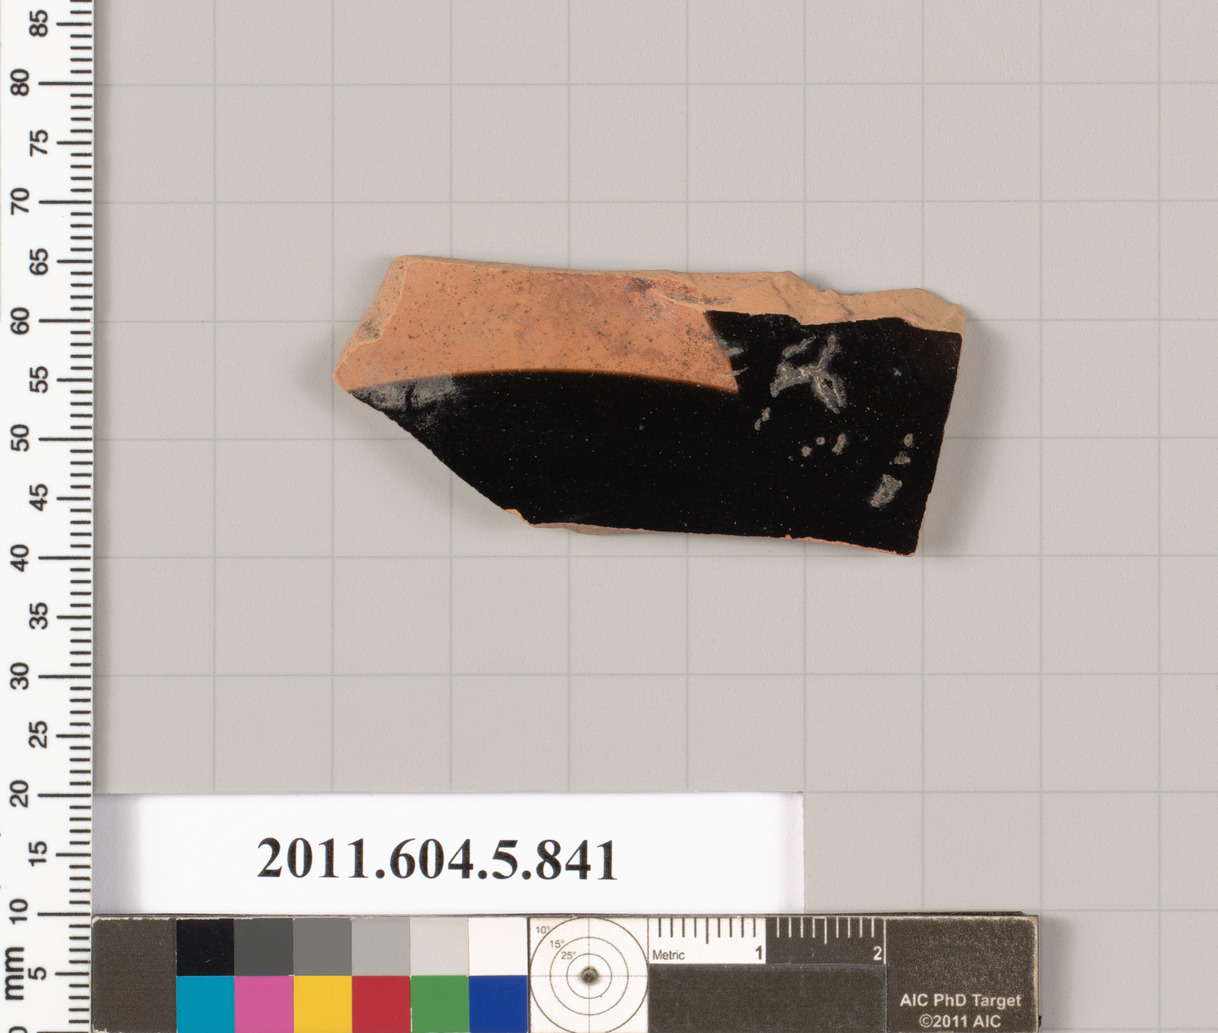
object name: kylix fragment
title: Terracotta fragment of a kylix (drinking cup)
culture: greek, attic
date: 600-401 BCE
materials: terracotta